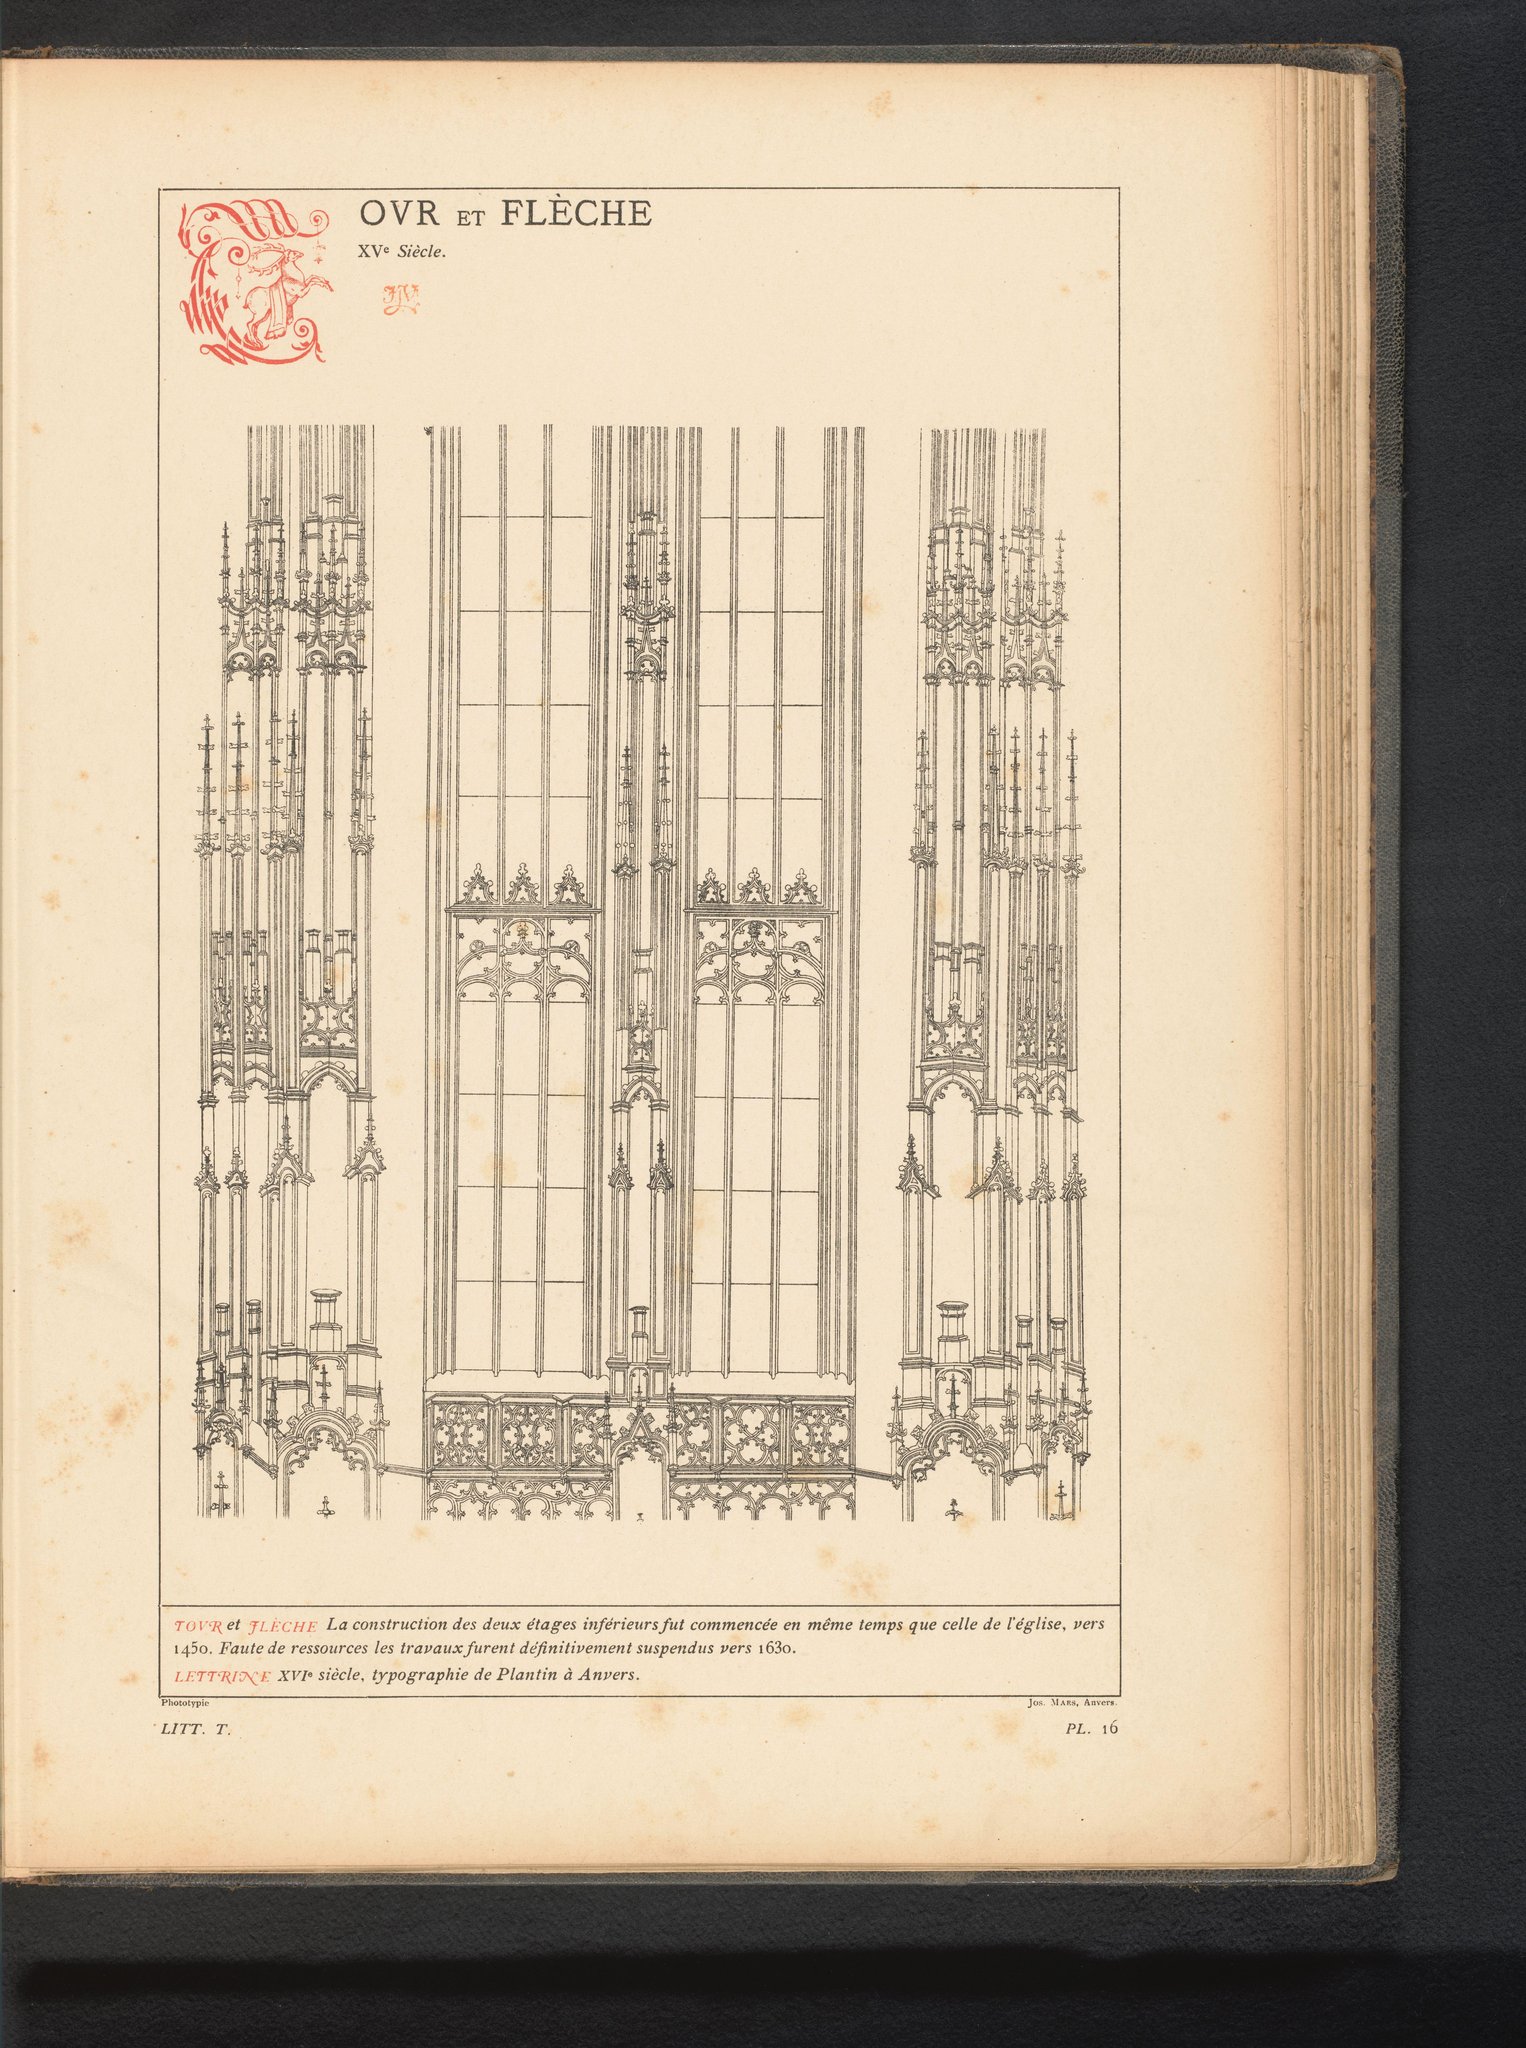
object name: reproduction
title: Reproductie van een prent van de ramen en torens van de Sint-Waltrudiskerk te Bergen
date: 1876-1881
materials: paper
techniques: photolithography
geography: antwerp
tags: church (exterior)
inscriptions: inscription: ‘LITT. T. - PL. 16.’, monogram: ‘JJvY’, inscription: ‘TOUR et FLÈCHE (...)’